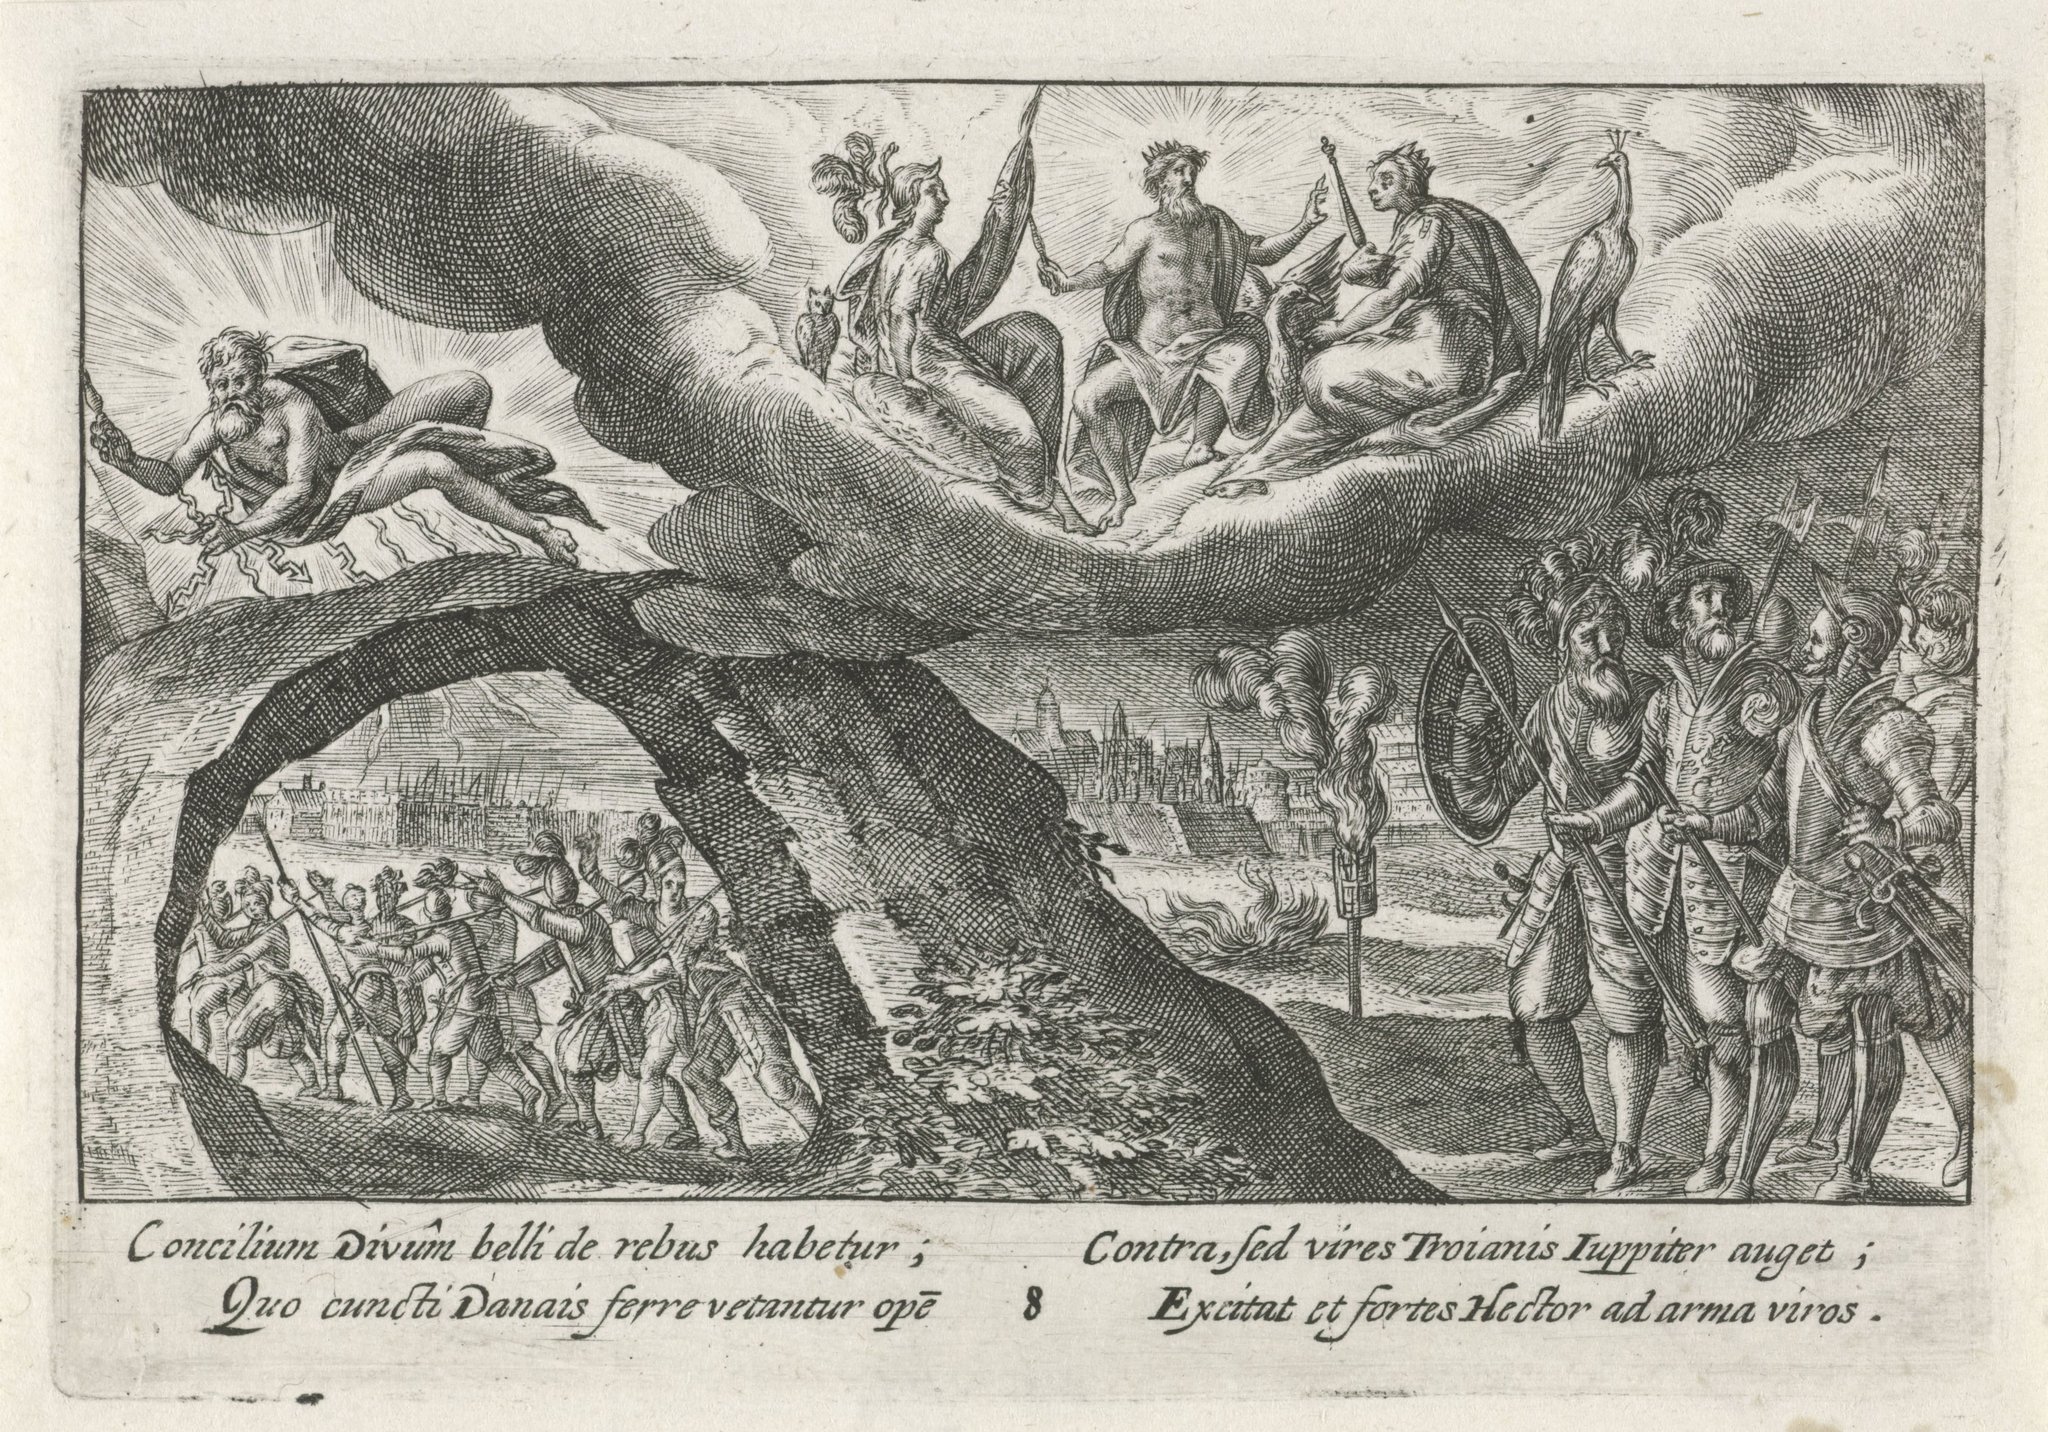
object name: print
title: Jupiter helpt de Trojanen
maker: crispijn van de passe (i)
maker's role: draughtsman, print maker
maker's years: 1564-1637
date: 1613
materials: paper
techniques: engraving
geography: utrecht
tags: (story of) jupiter (zeus)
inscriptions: number: ‘38-65’, collector's mark: Lugt 240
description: Jupiter versterkt het Trojaanse leger en verbiedt Juno en Minerva om mee te vechten. In de marge een vierregelig onderschrift, in twee kolommen, in het Latijn.